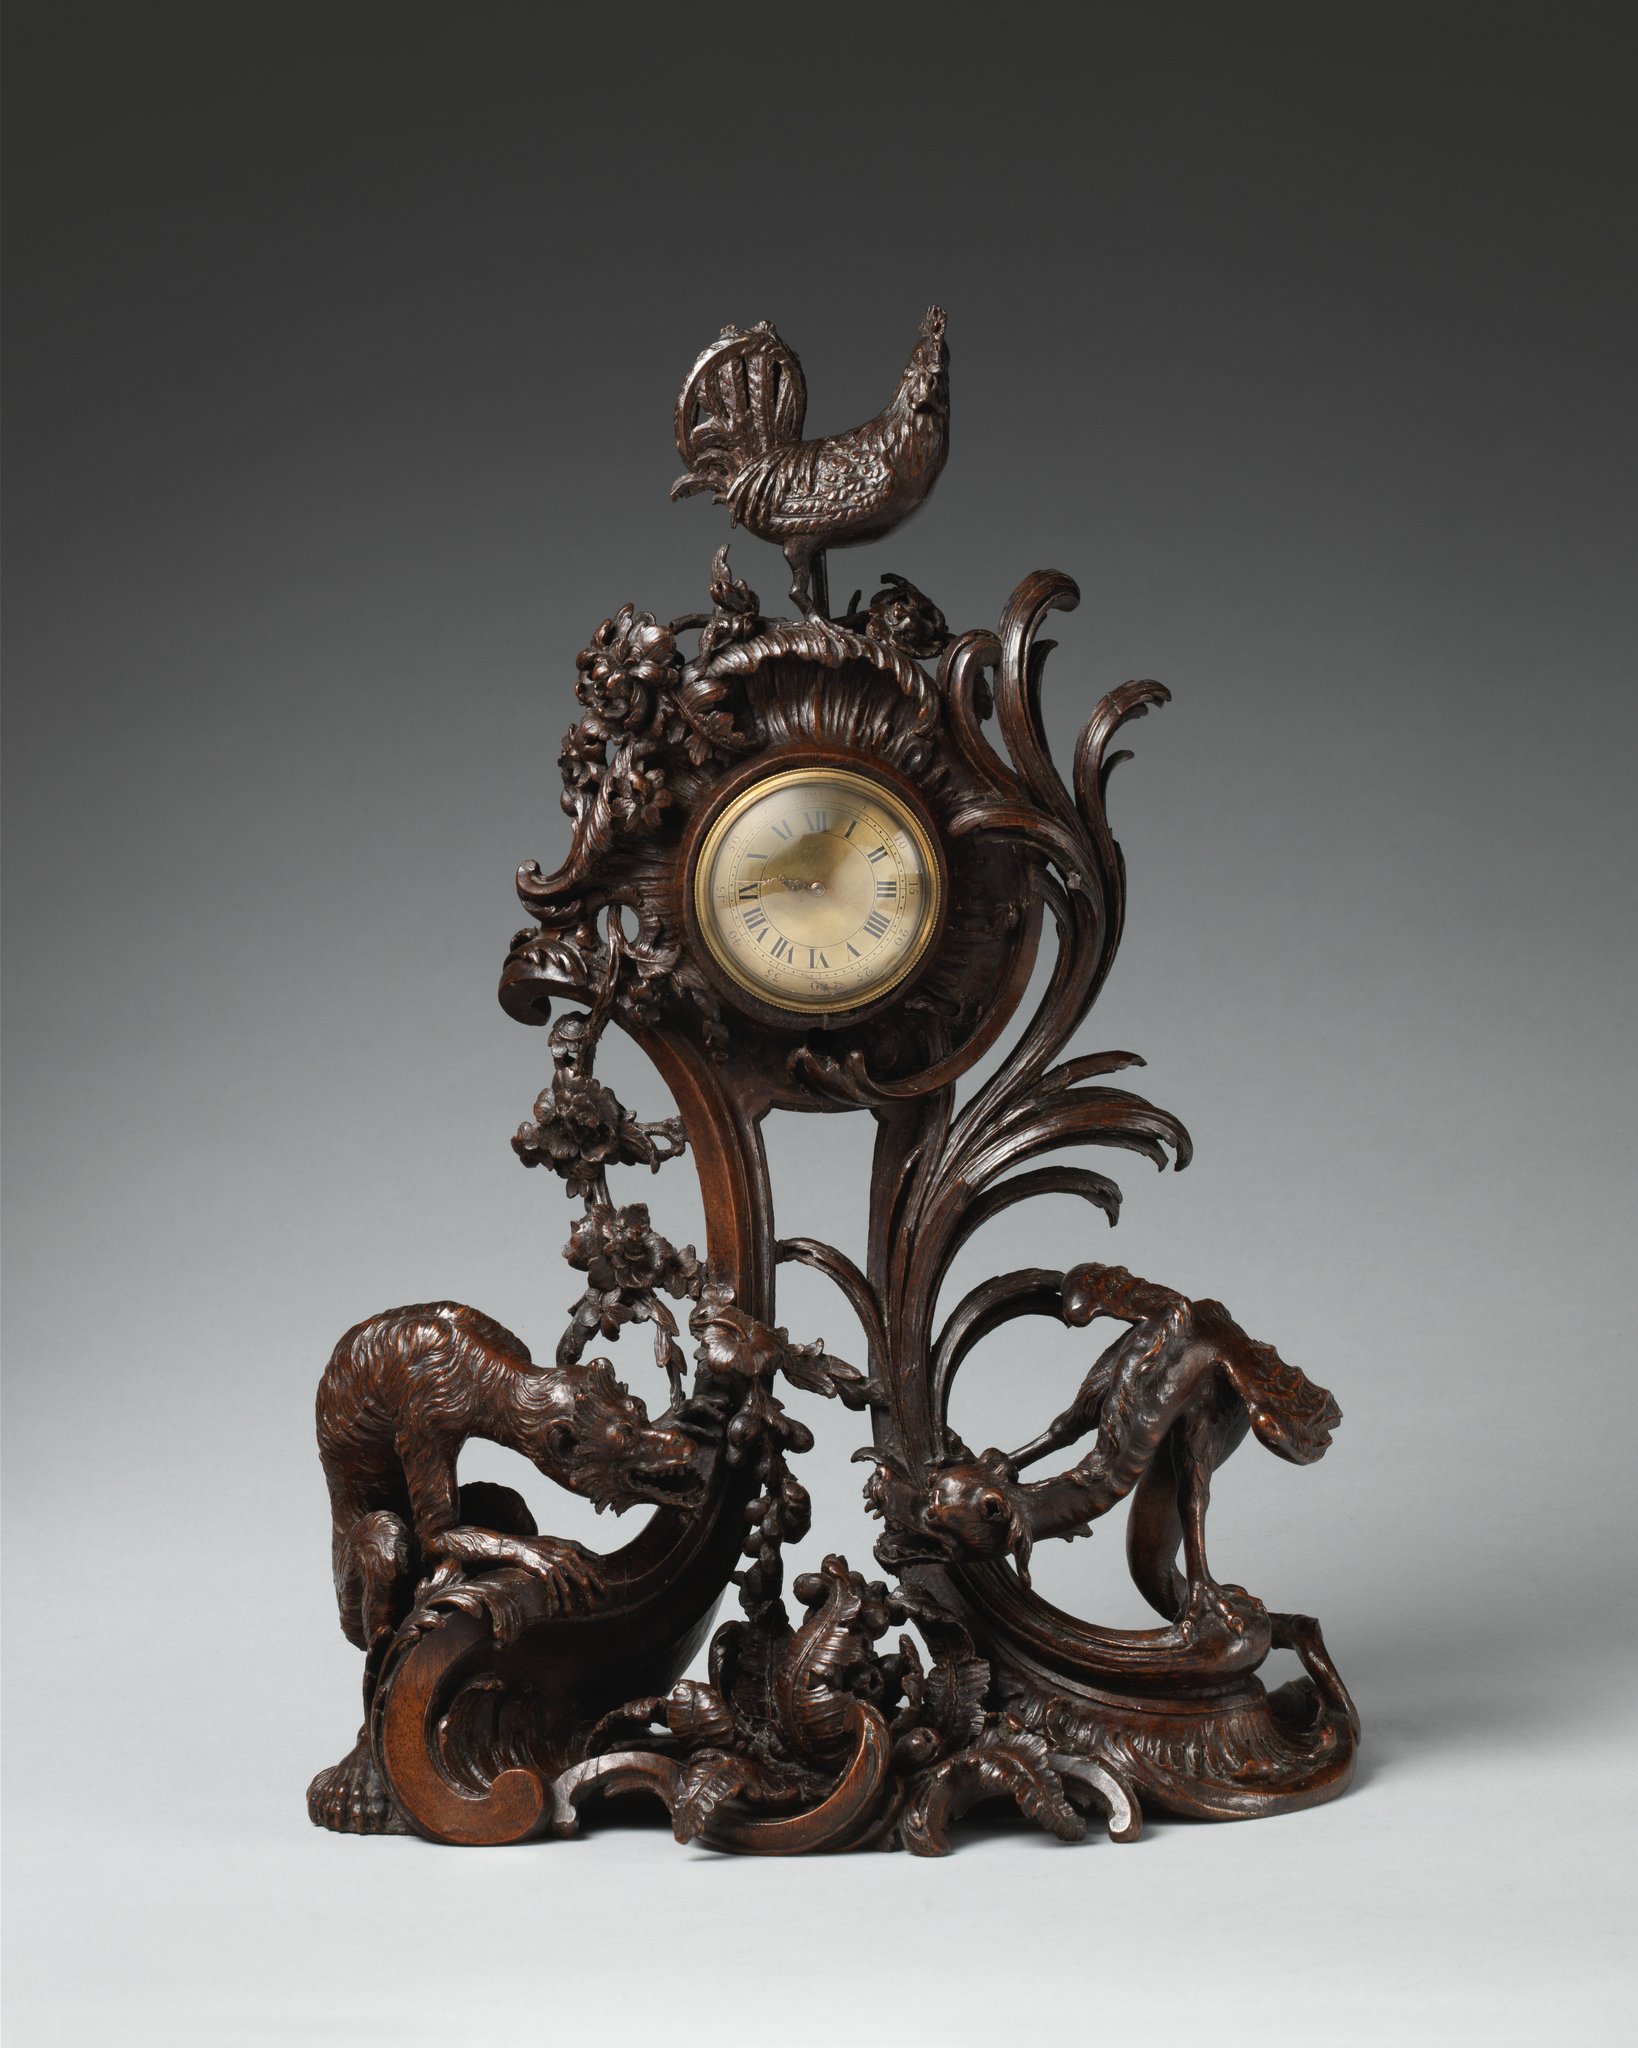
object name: watch stand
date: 1760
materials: wood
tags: dragons,roosters,monkeys